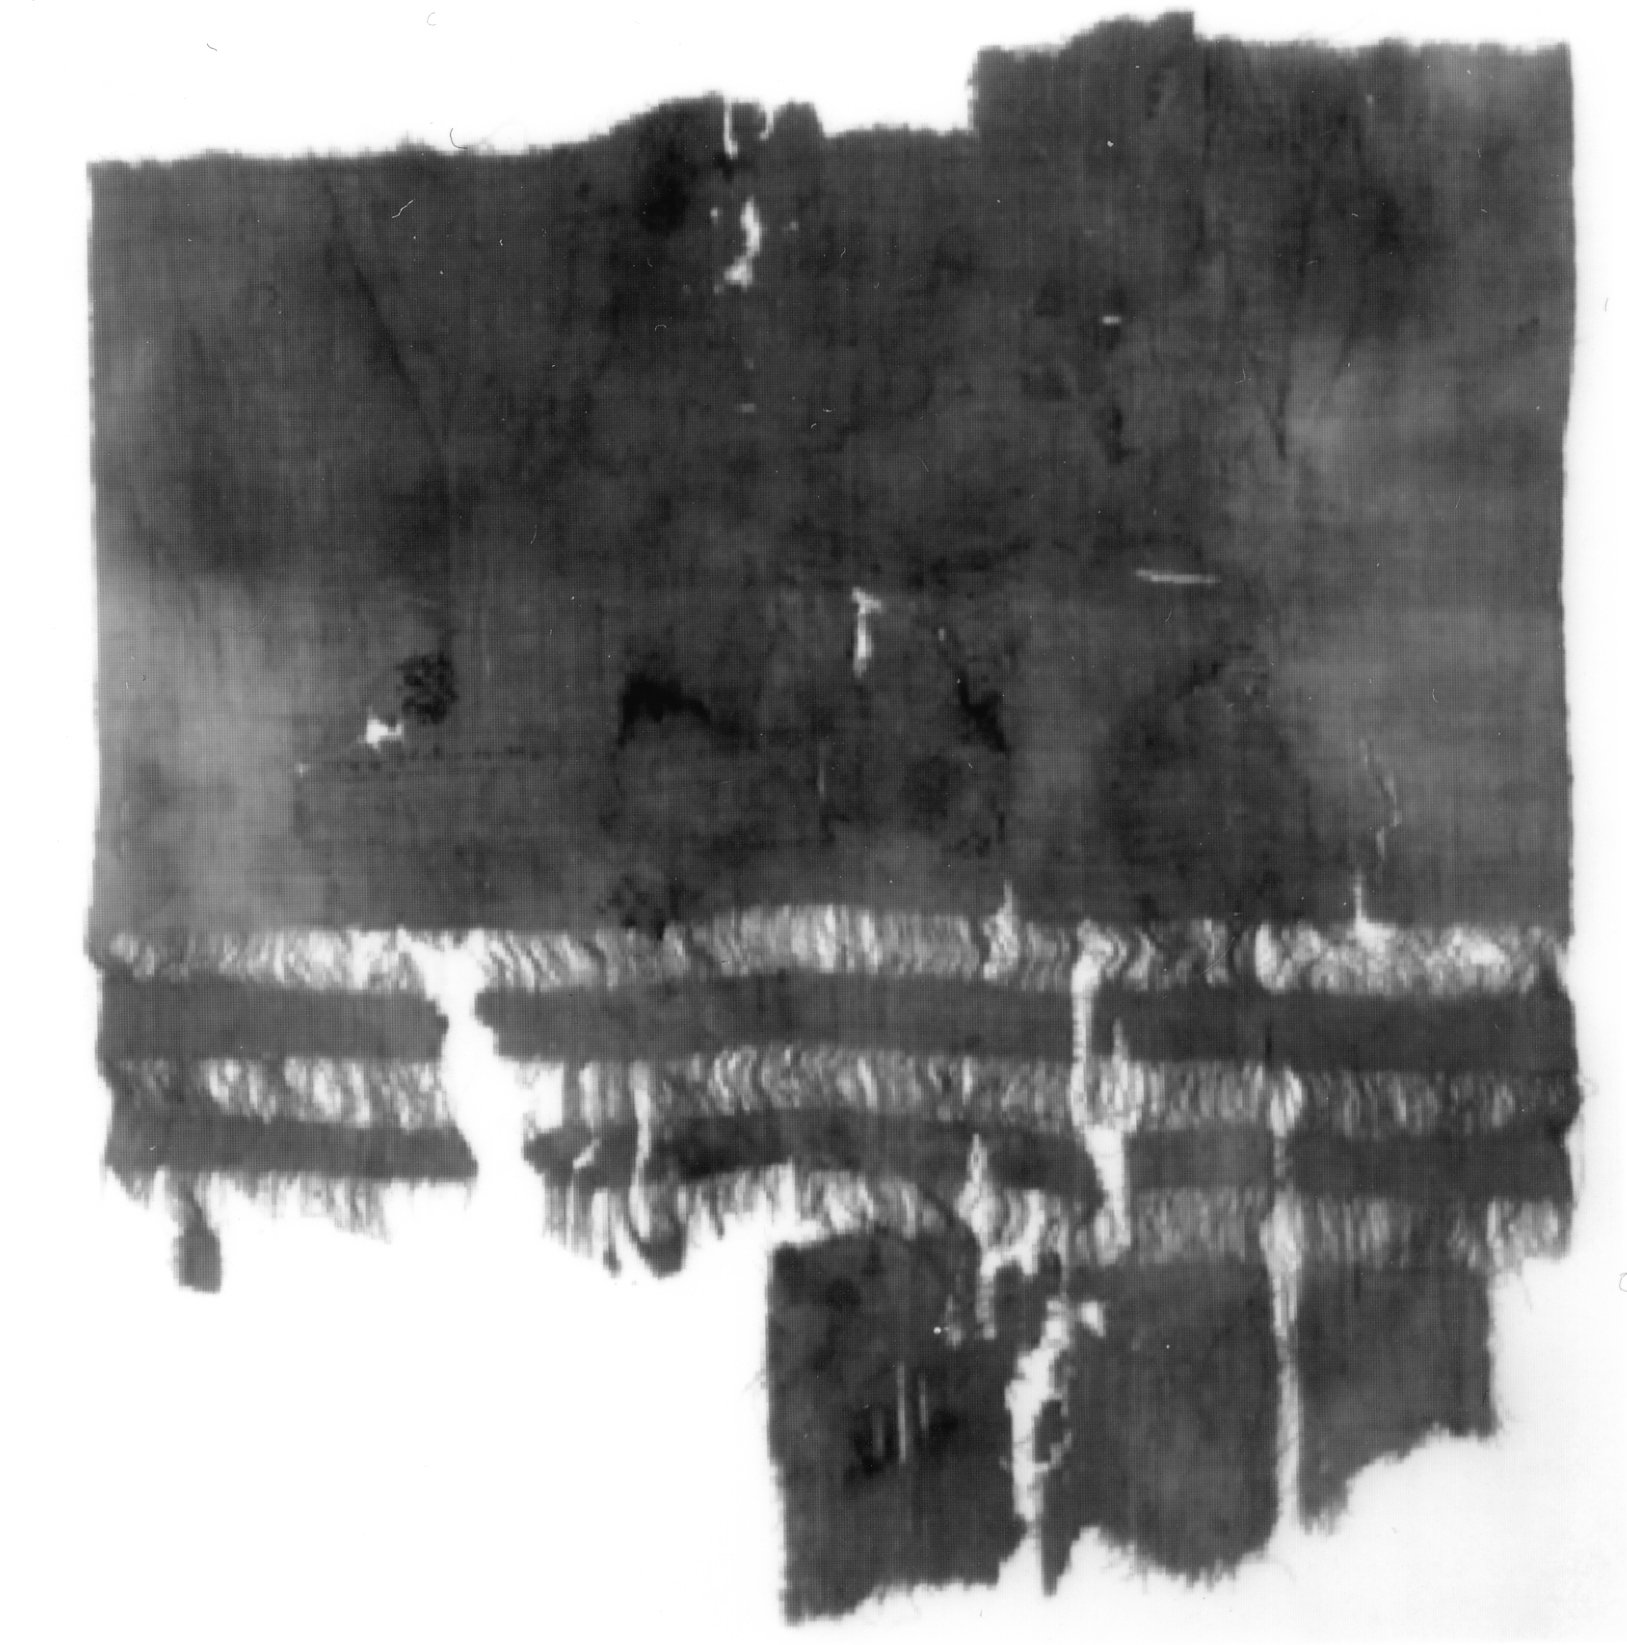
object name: fragment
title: Sheet Fragment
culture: coptic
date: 301-400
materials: linen, wool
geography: egypt